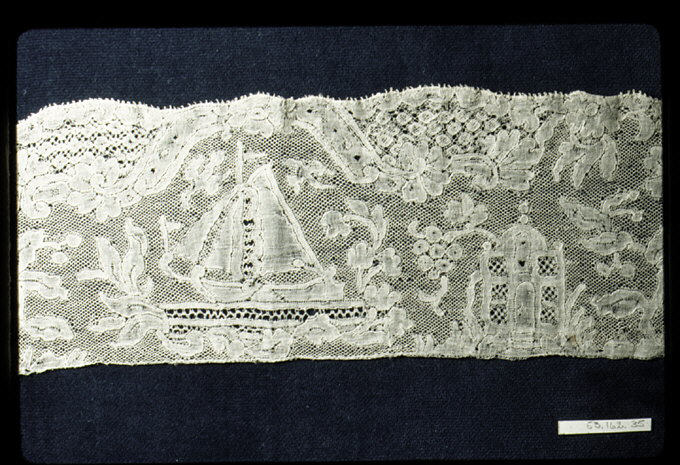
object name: border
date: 1701-1800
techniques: lace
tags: flowers,boats